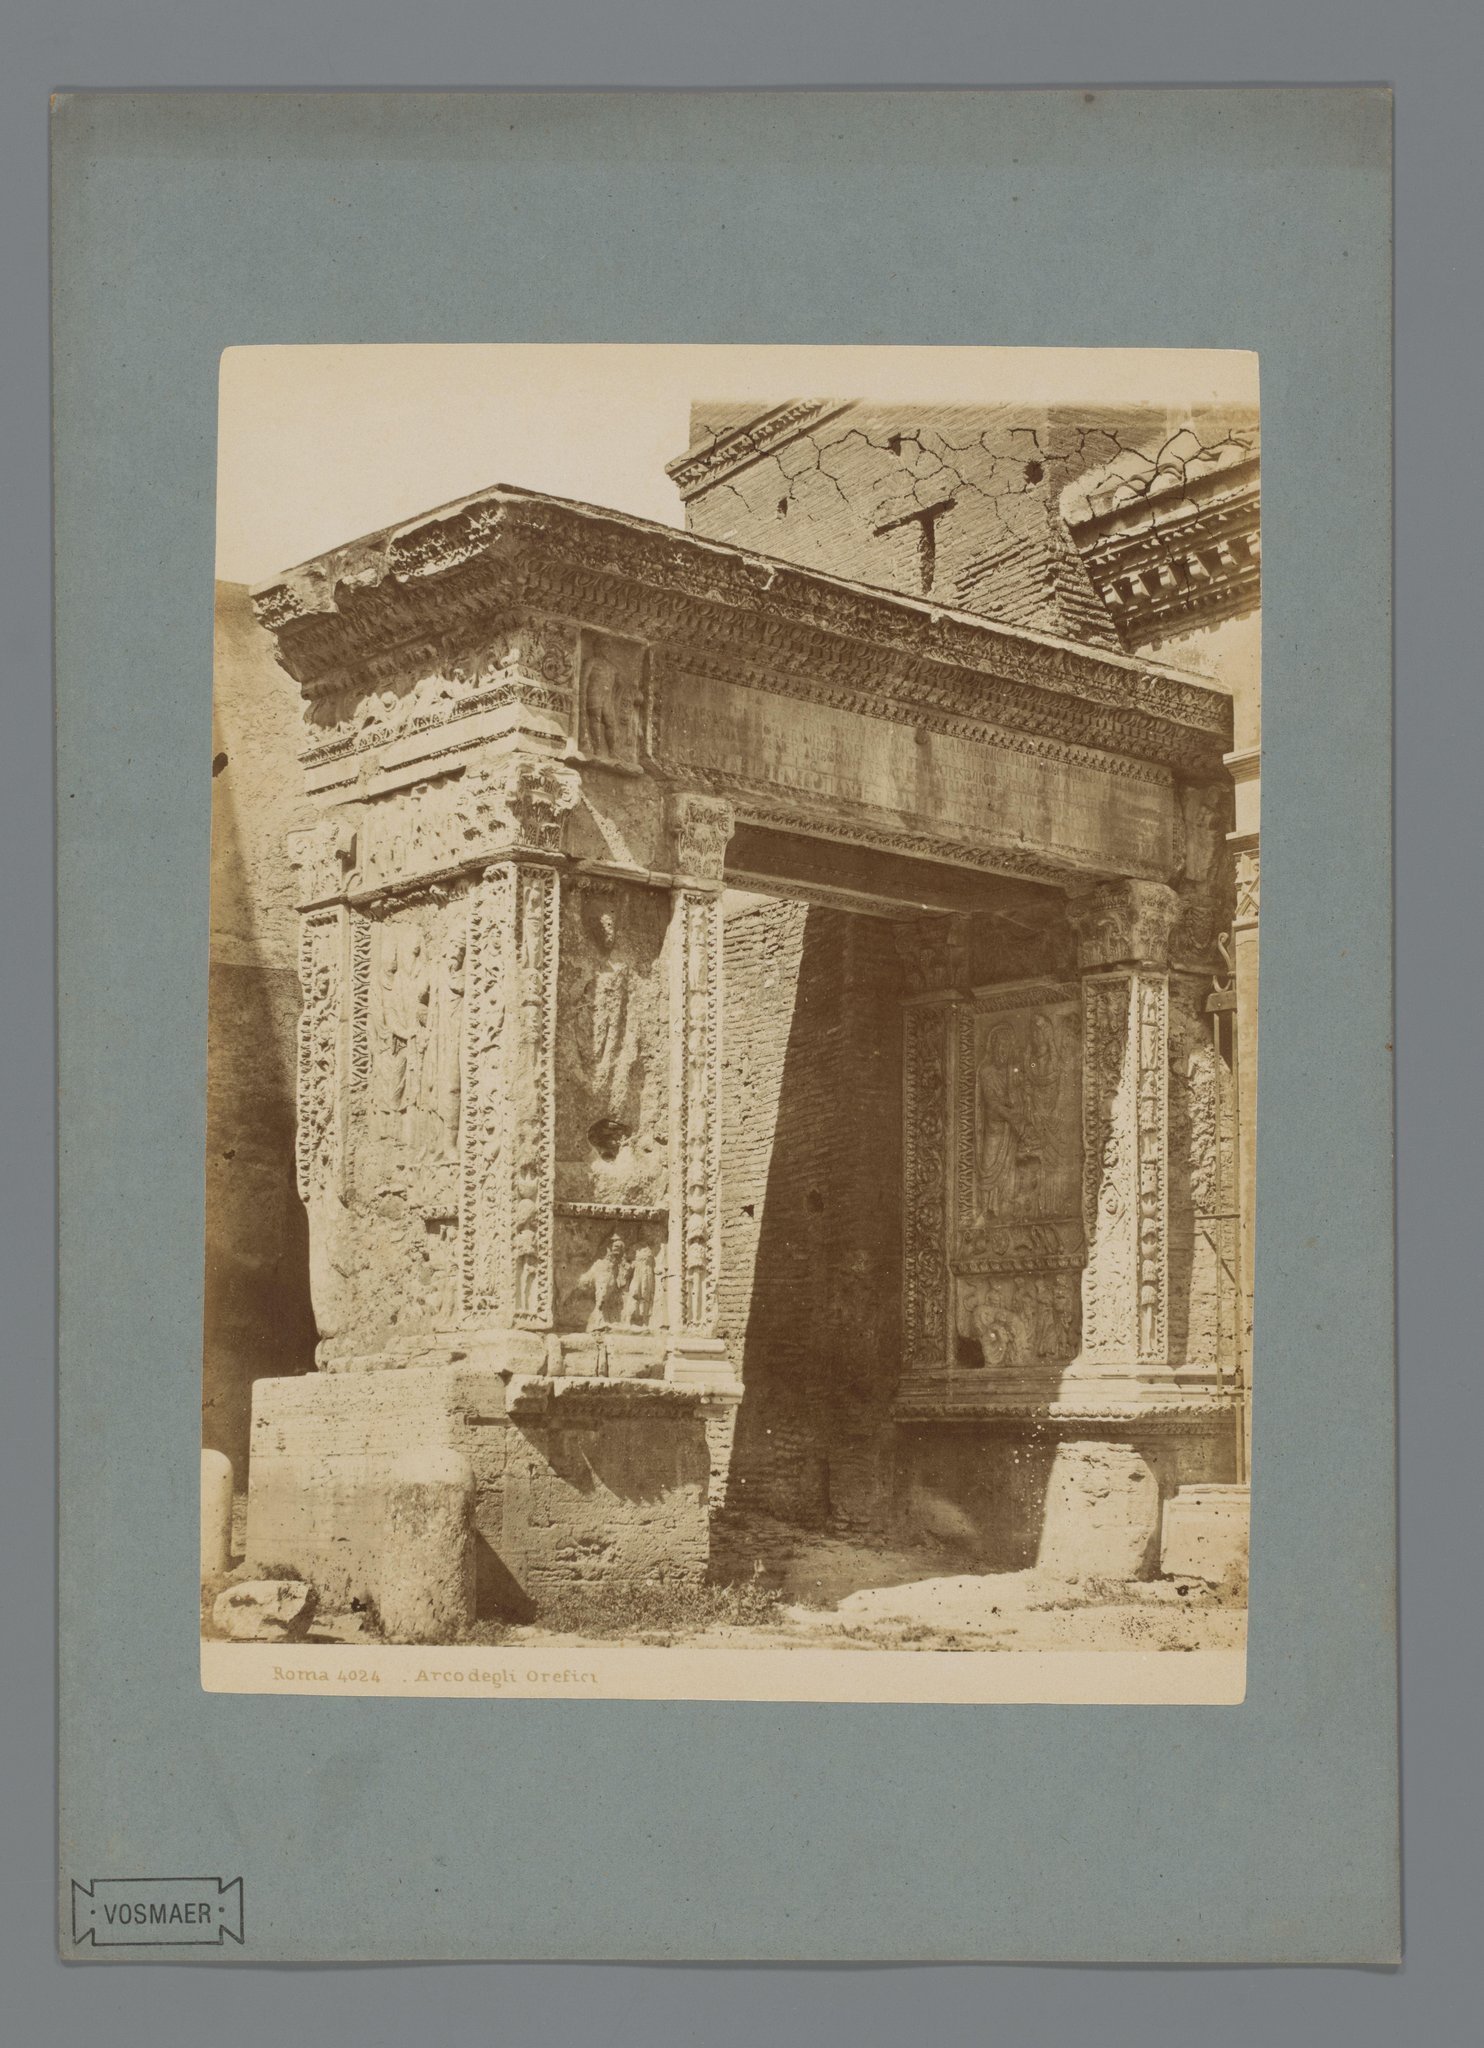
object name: photograph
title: Gezicht op de Boog van de geldwisselaars in Rome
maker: Anonymous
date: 1869-1900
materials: cardboard, paper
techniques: albumen print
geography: rome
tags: parts of church exterior and annexes: façade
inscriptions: number: ‘4024.’, collector's mark: ‘VOSMAER’